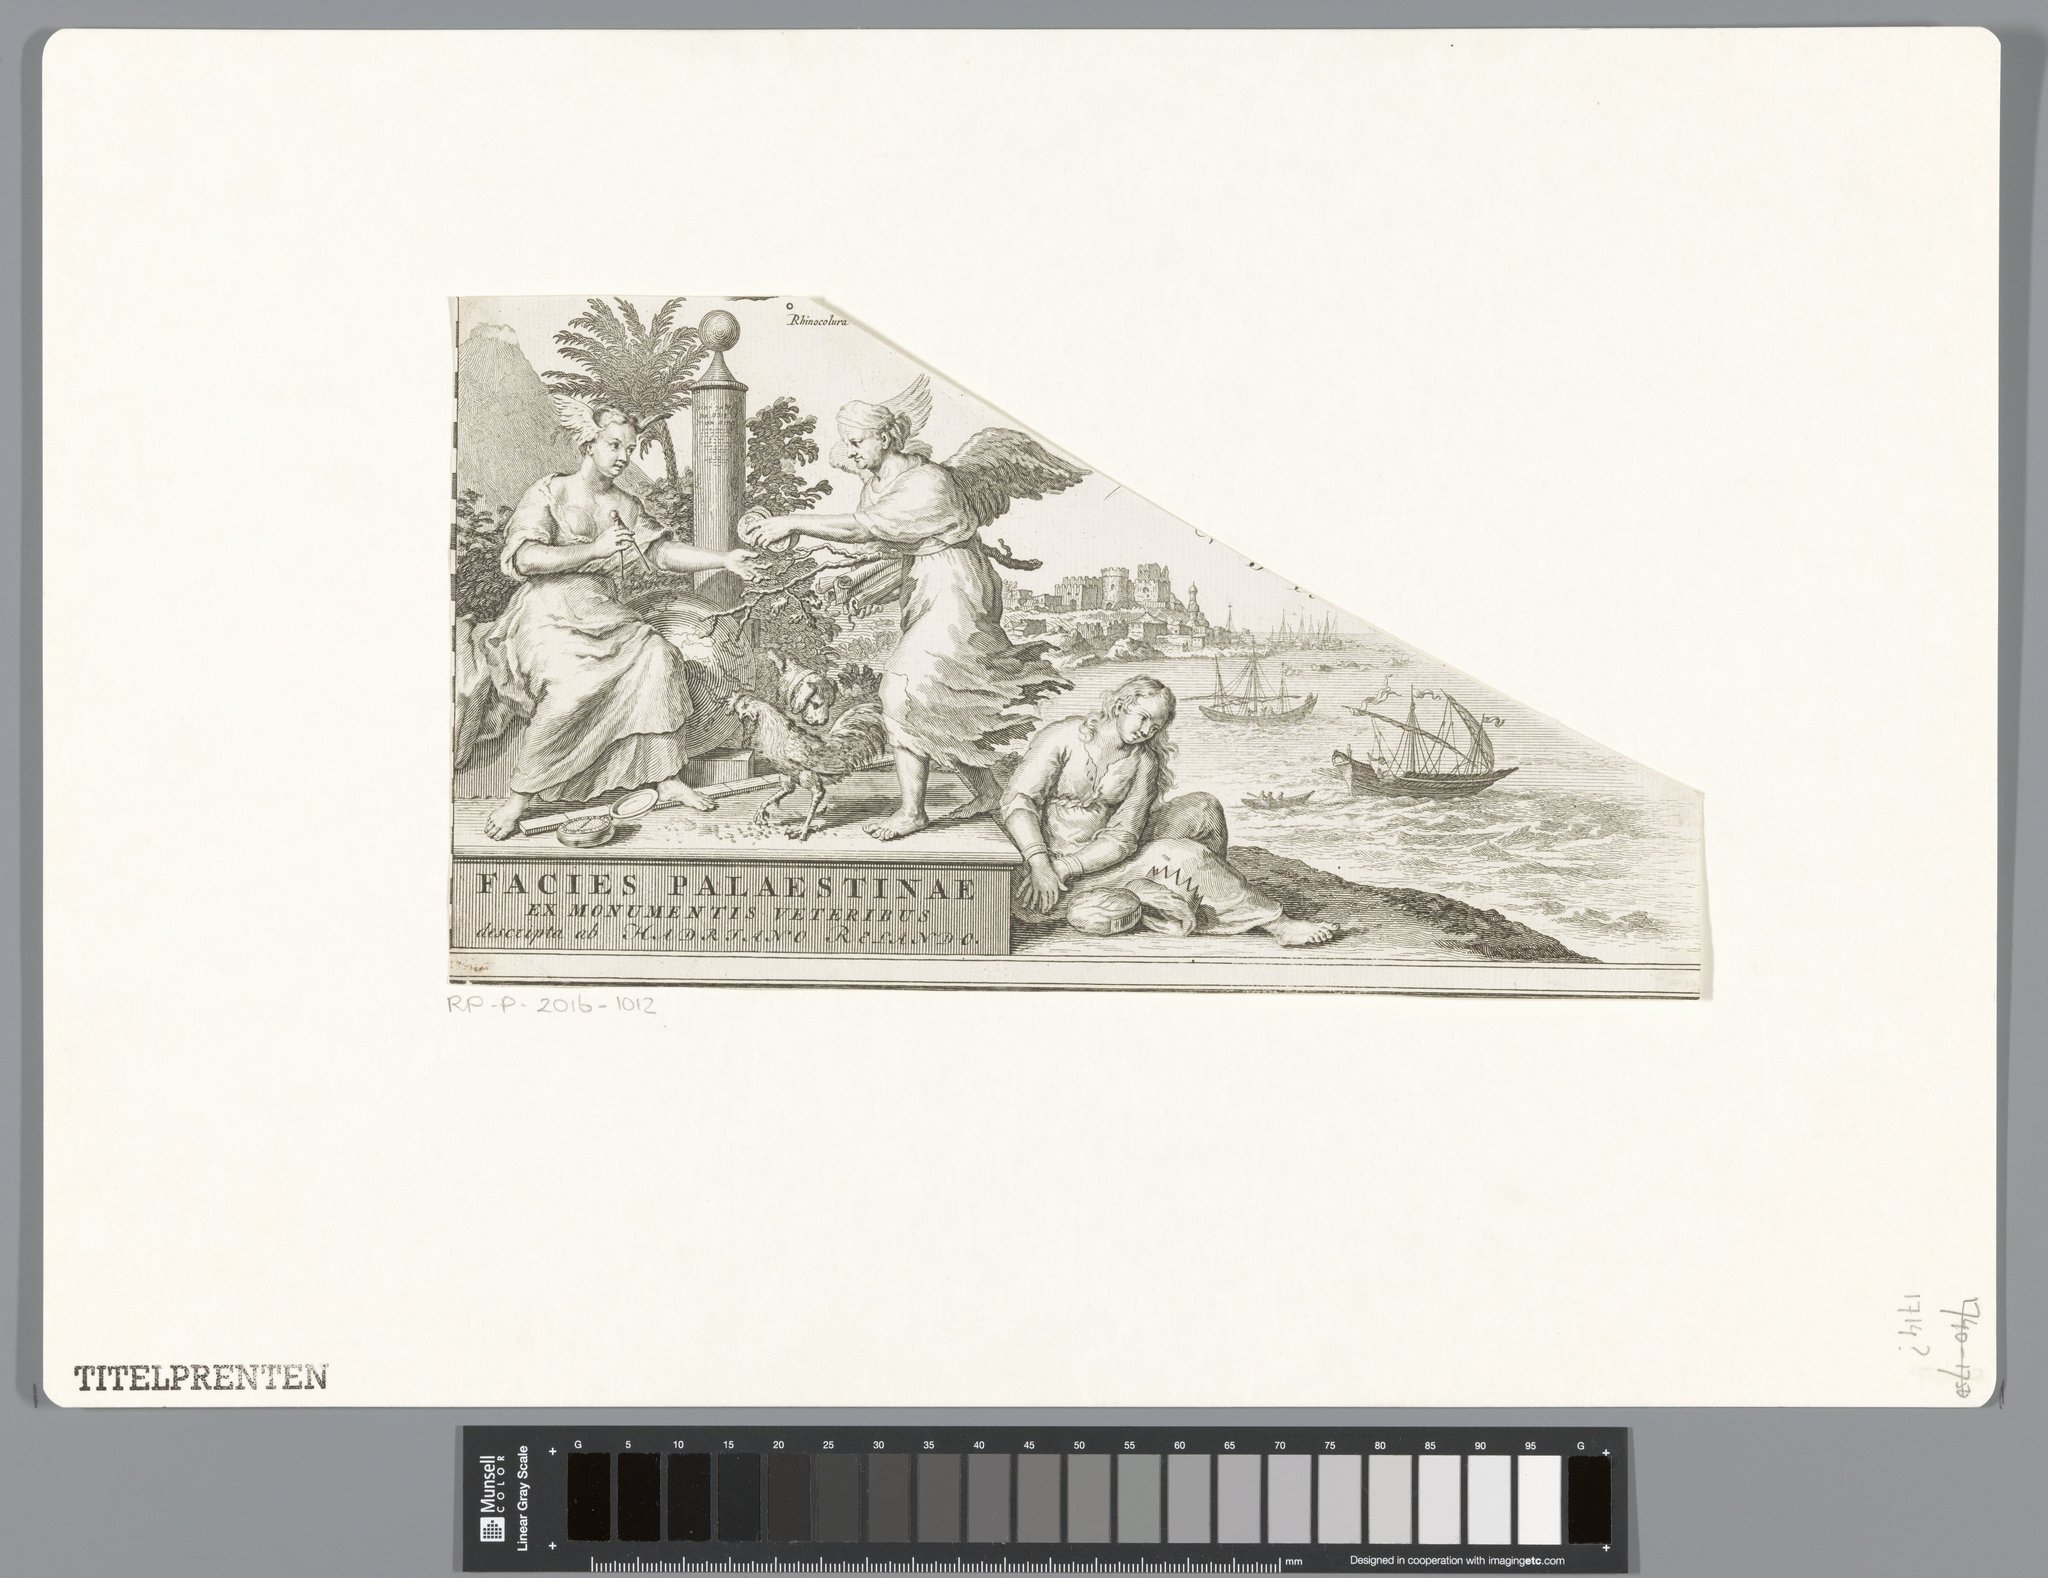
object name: book illustration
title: Allegorische voorstelling met vrouw met meetinstrumenten en engel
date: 1714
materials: paper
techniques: engraving, etching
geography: utrecht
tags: measuring-instruments, prisoner; in fetters, angels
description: Op een verhoging zit een vrouw met passer en vleugels aan het hoofd naast een globe. Bij haar voeten liggen een meetlat en kompas. Een engel met een tak en boekrollen in de hand overhandigt haar munten. Tussen de twee figuren staan een haan en een hond. Rechts tegen de verhoging zit een geboeide figuur als personificatie van het verslagen koninkrijk Judea, bij haar liggen een tulband en kroon. In de achtergrond een gezicht op de stad Jaffa aan zee waarop zeilschepen varen. De voorstelling is onderdeel van een kaart van Palestina en Israël.